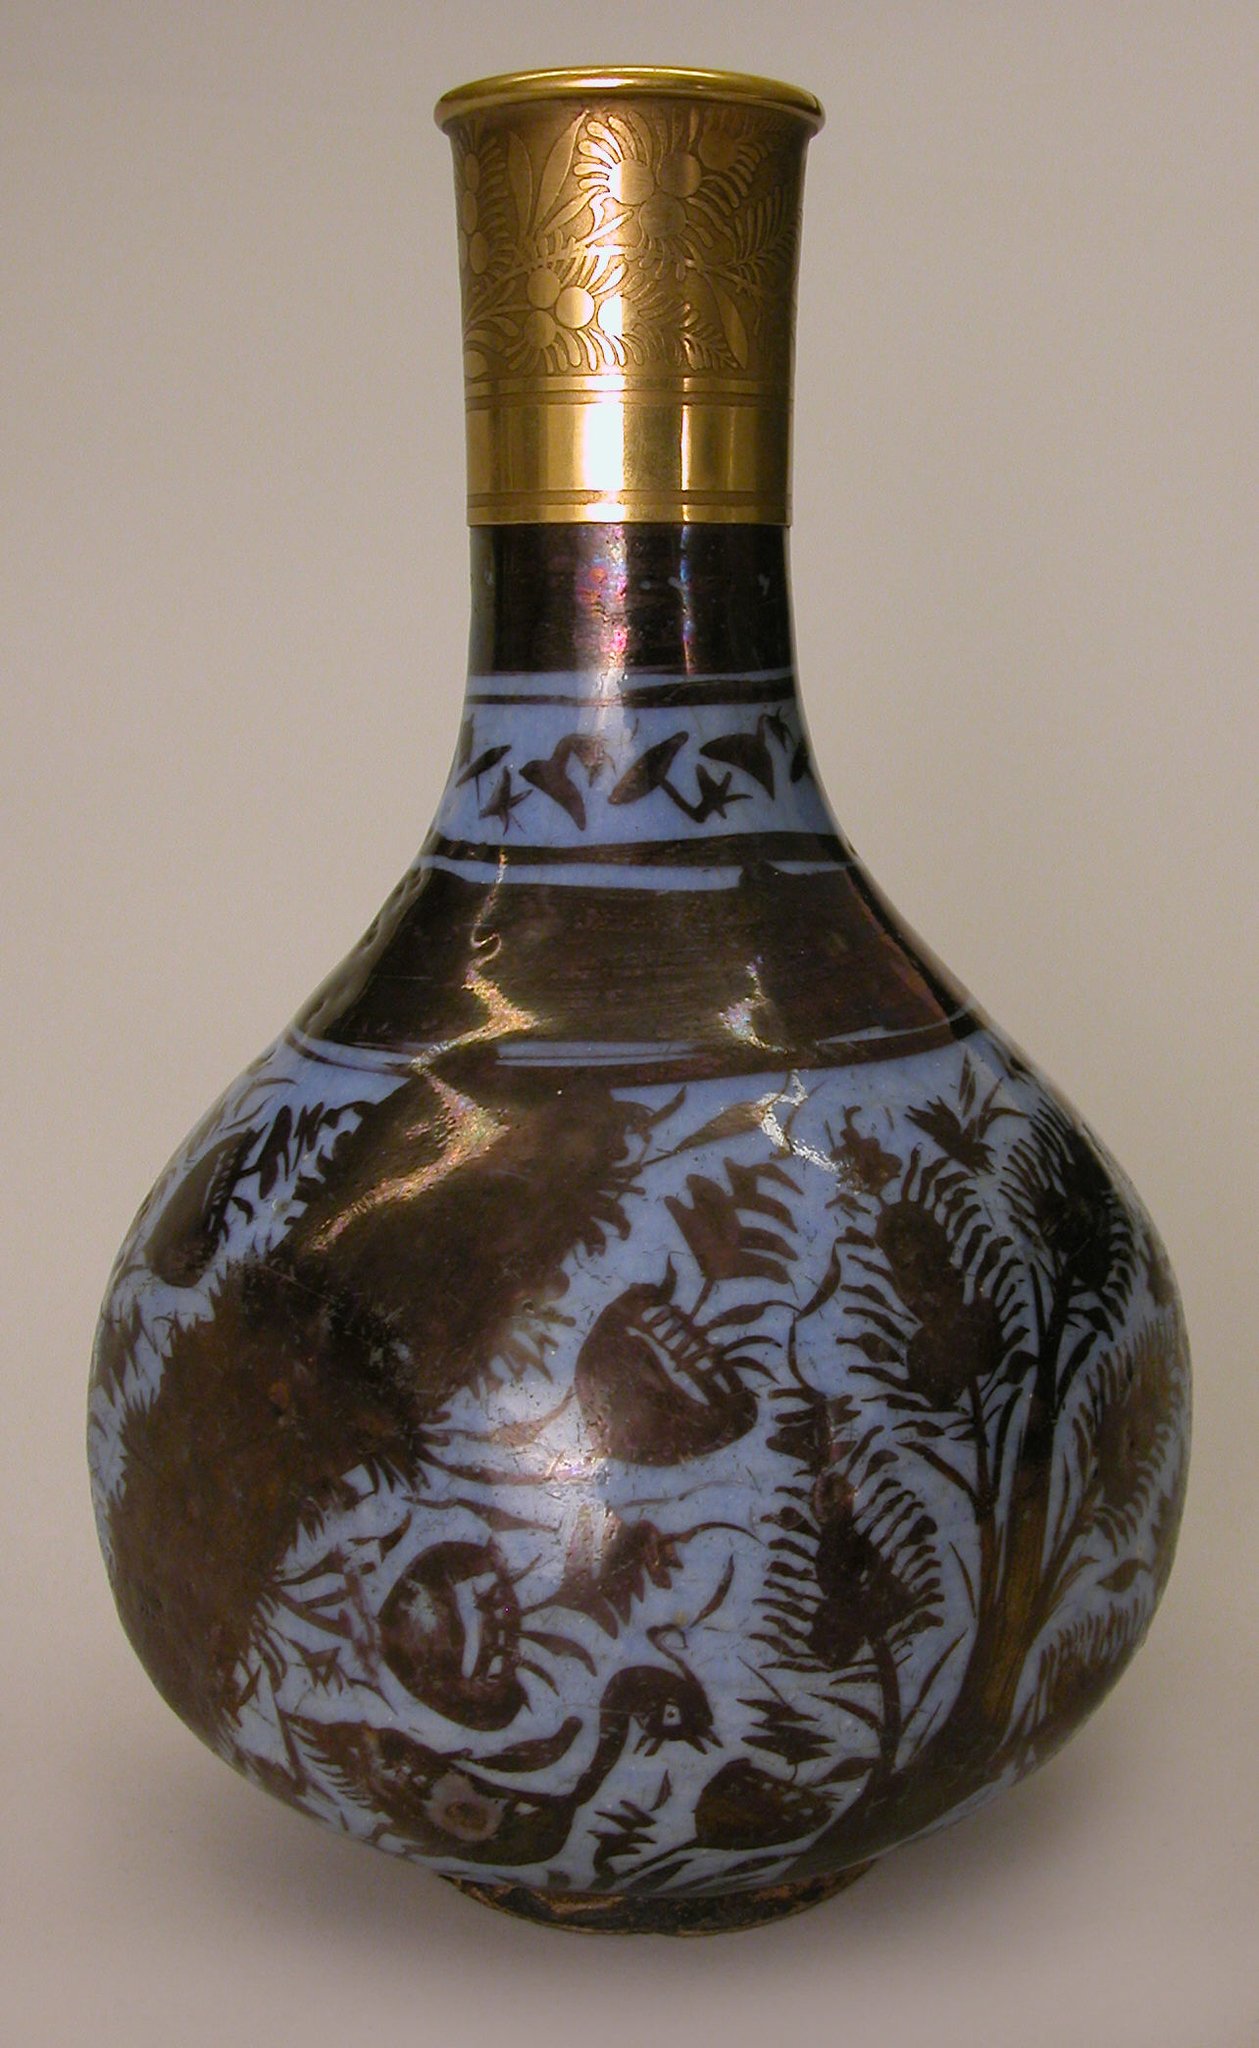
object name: bottle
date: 1601-1700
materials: copper gilt, glaze, stonepaste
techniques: luster painting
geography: iran